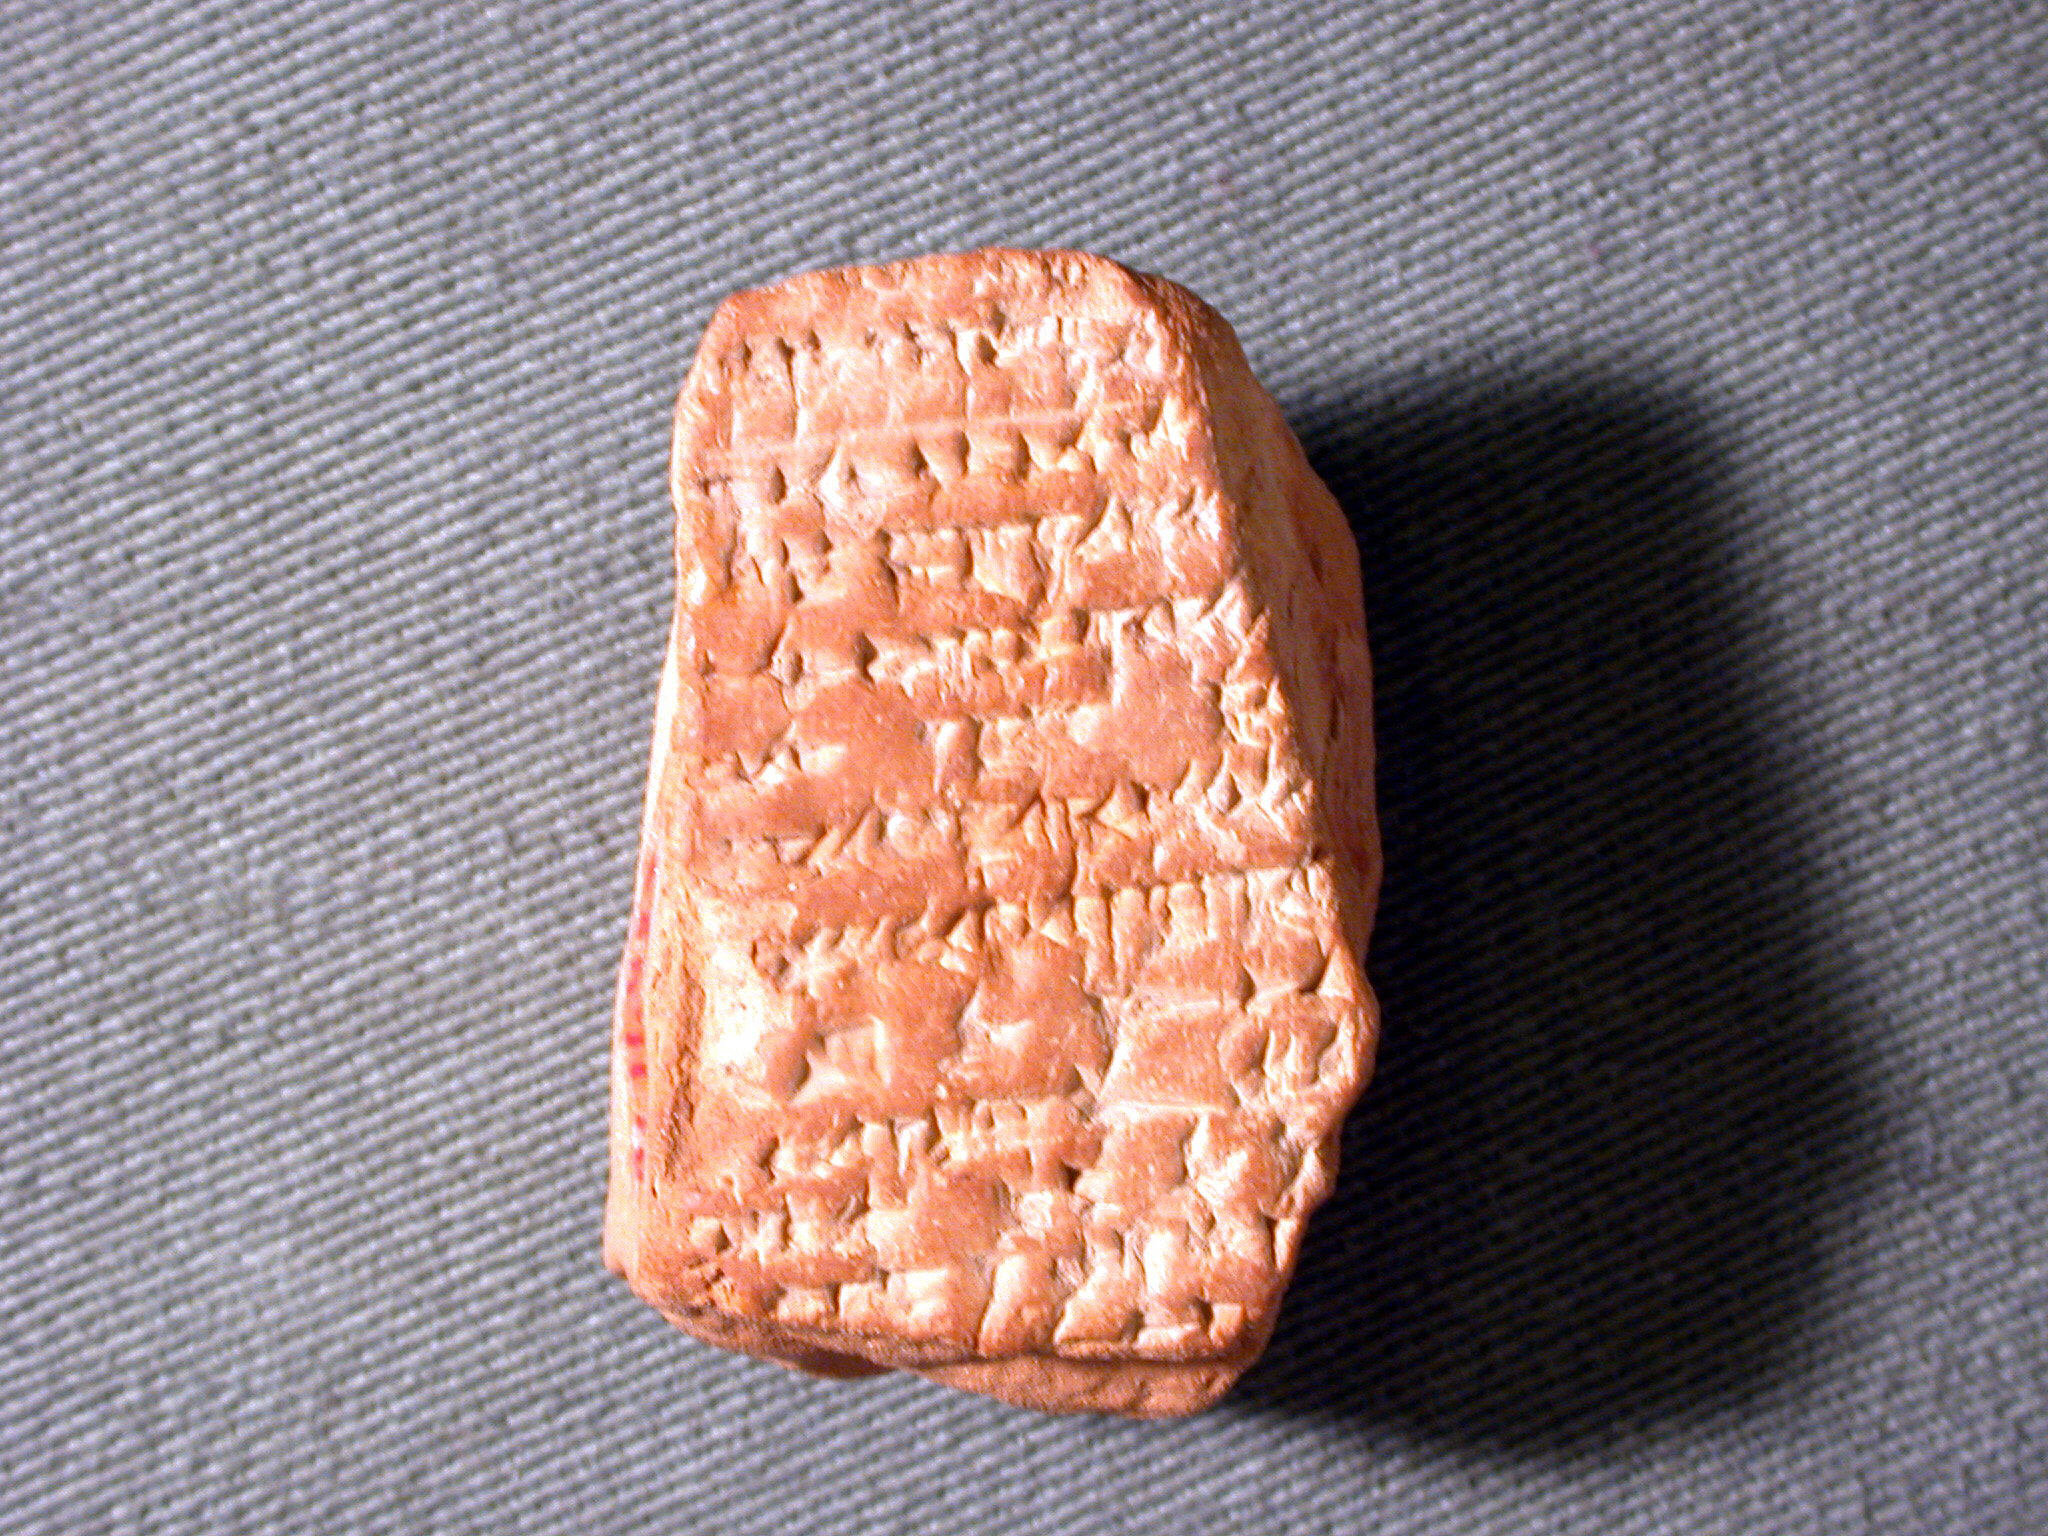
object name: cuneiform tablet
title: Cuneiform tablet: fragment of a litigation settlement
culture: achaemenid or babylonian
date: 700-301 BCE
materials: clay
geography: mesopotamia